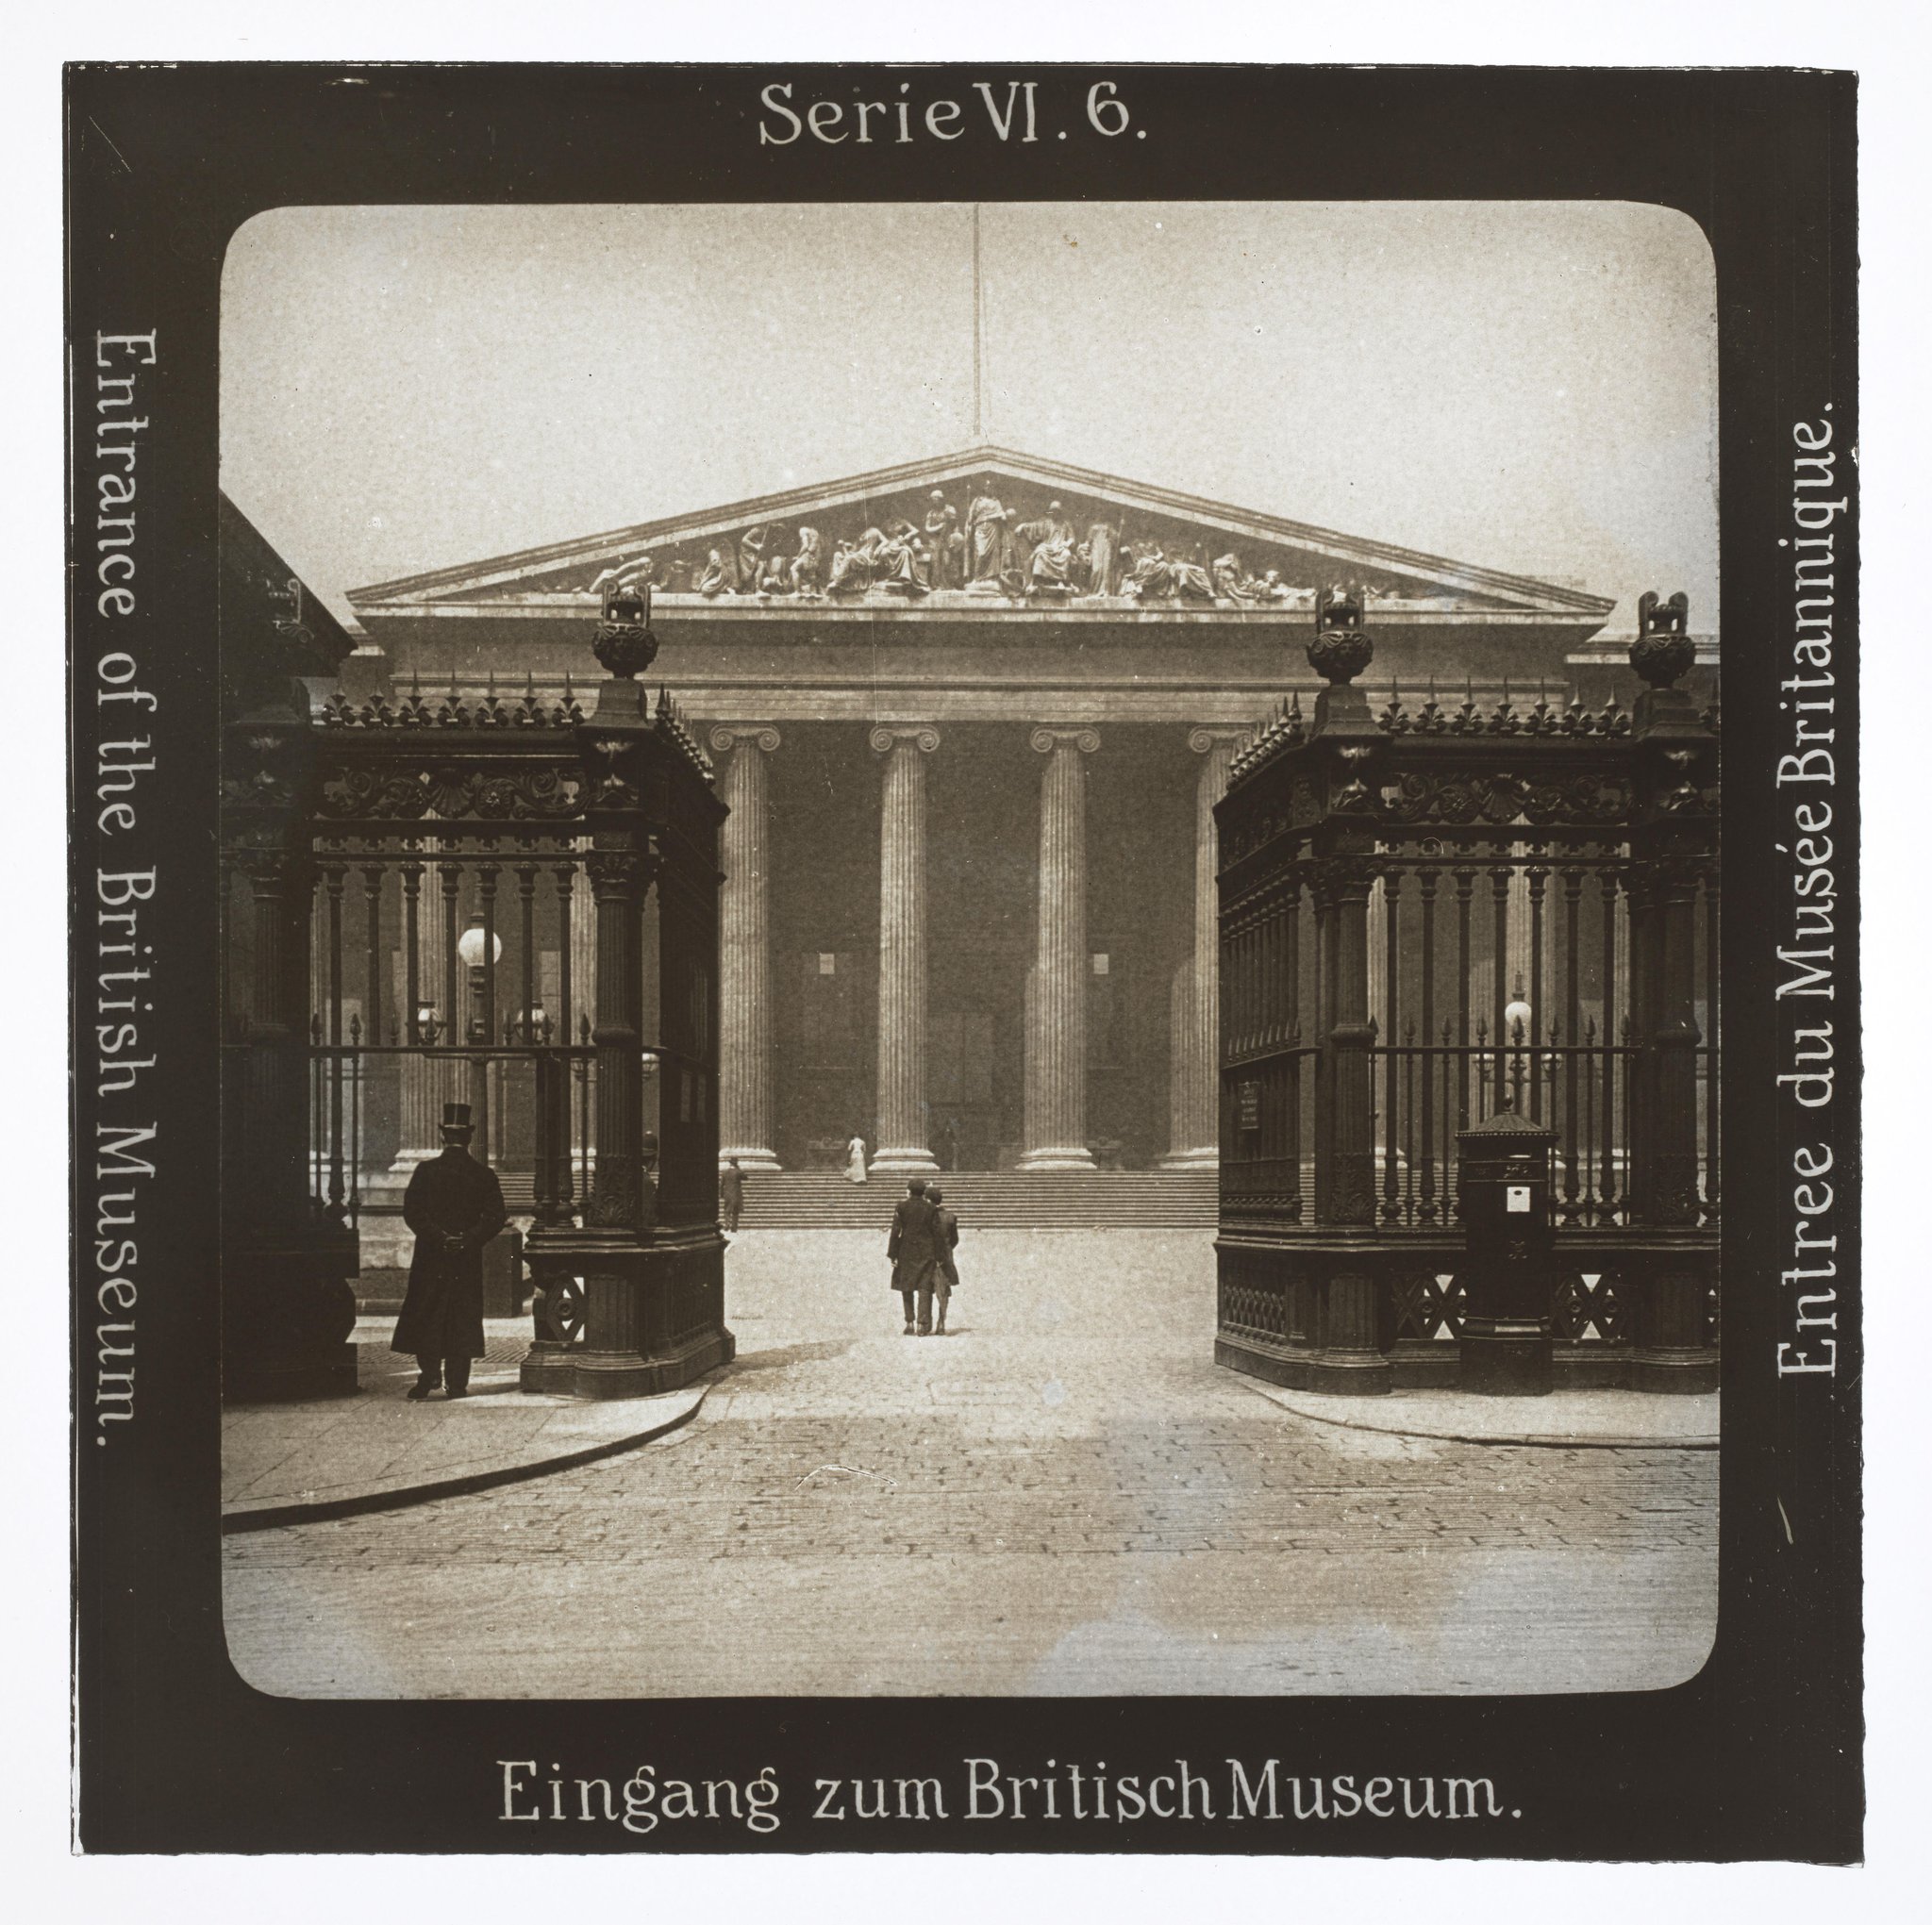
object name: lantern slide photographic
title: Eingang zum Britisch Museum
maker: Anonymous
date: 1900-1906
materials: glass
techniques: gelatin silver transparency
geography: germany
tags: gate, entrance, permanent exhibition, museum